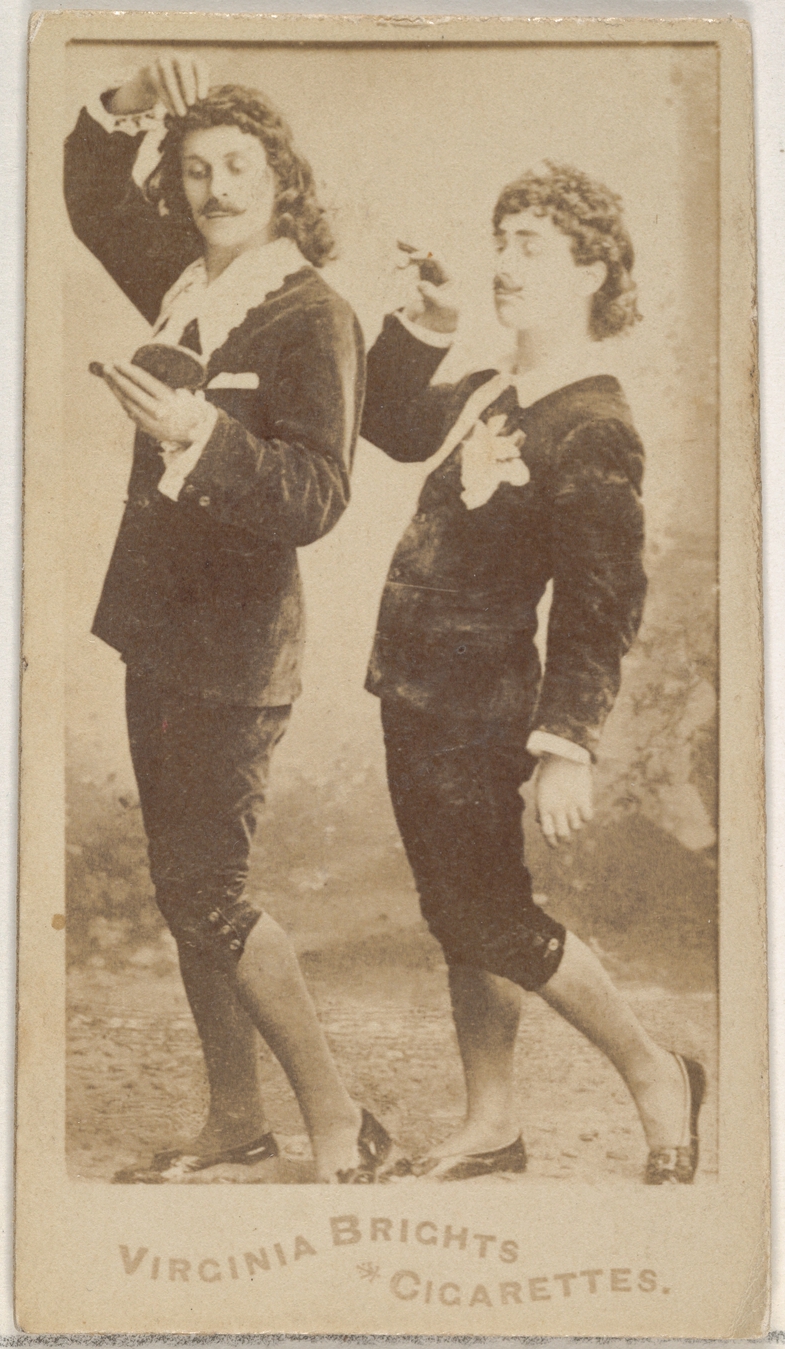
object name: photograph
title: From the Actors and Actresses series (N45, Type 5) for Virginia Brights Cigarettes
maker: allen & ginter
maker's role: publisher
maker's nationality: american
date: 1888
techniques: albumen silver print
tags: men,portraits,actors